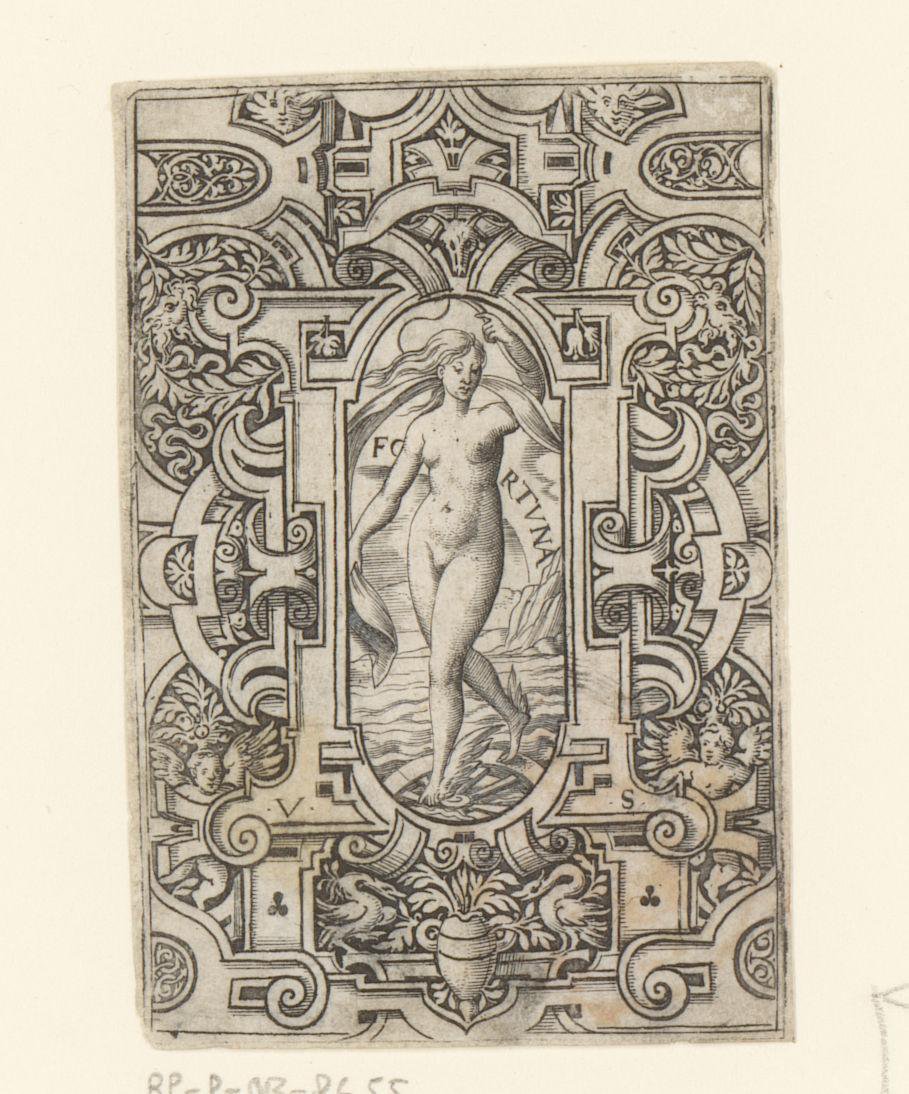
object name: print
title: Fortuna in rolwerk omlijsting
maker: virgilius solis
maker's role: draughtsman, print maker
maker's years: 1514-1562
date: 1524-1562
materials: paper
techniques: engraving, etching, intaglio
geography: nuremberg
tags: fortuna as roman personification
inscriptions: collector's mark: Lugt 240